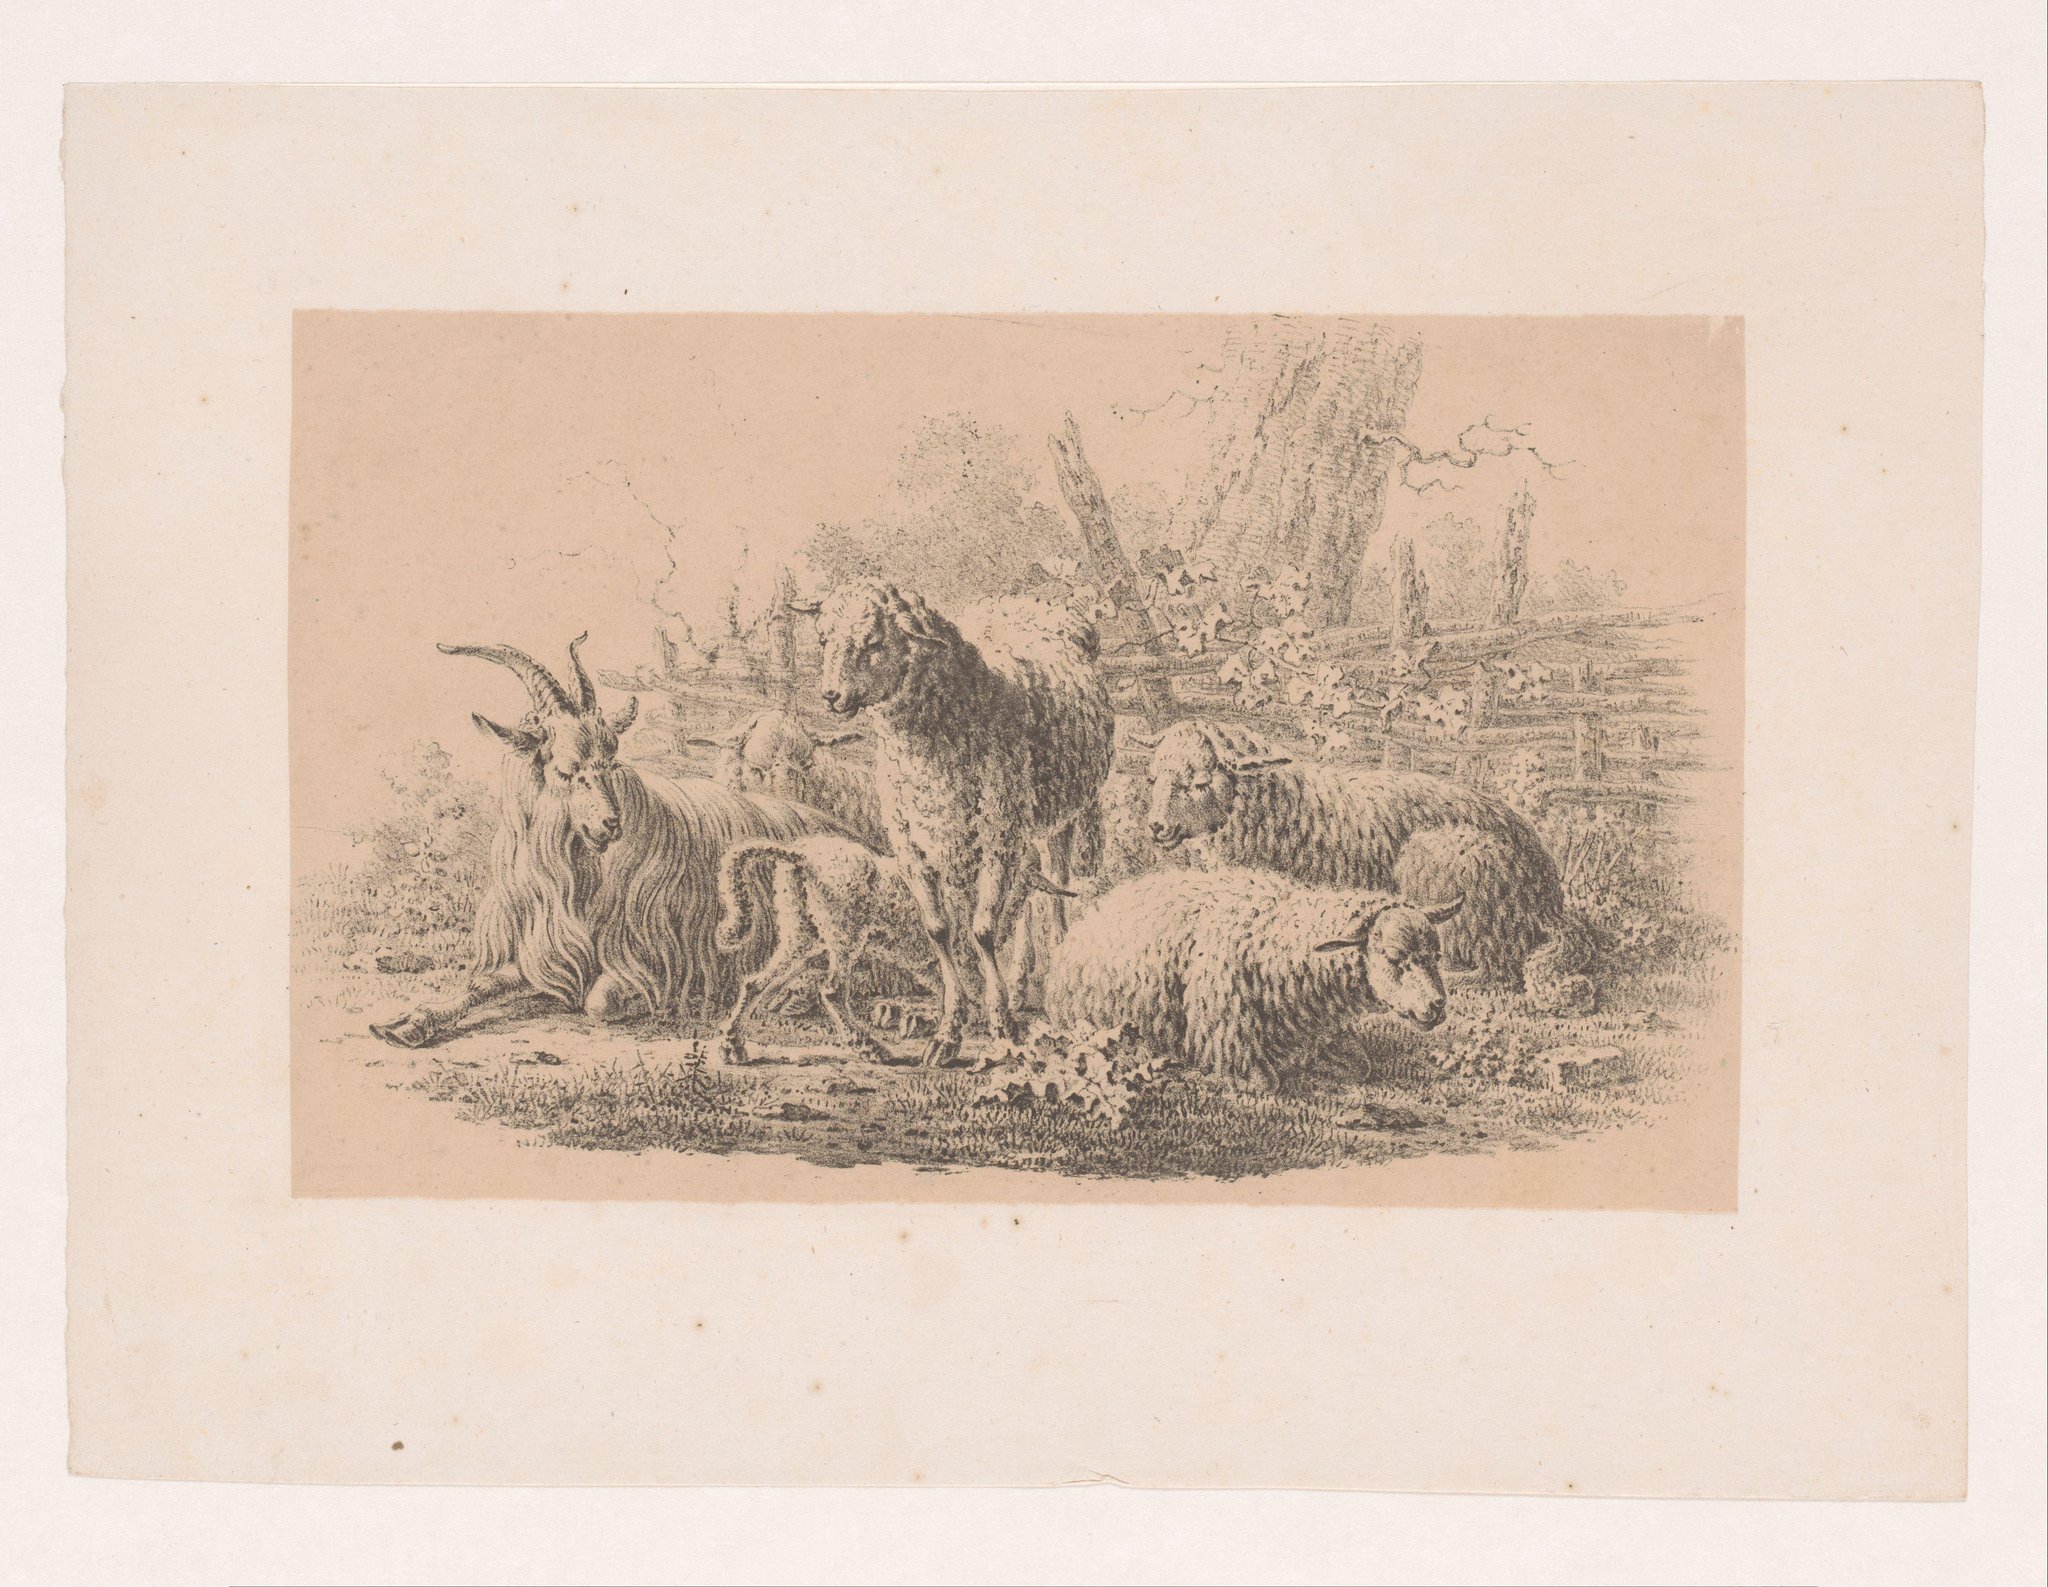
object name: print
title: Geitenbok, vijf schapen en een lam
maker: pieter de goeje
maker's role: draughtsman, print maker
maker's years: 1789-1859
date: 1809-1859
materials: paper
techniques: tone lithography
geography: netherlands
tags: sheep (+ feeding and care of young), fence, wall, paling, he-goat, billy-goat, lamb, ewe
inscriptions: collector's mark: Lugt 2228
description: Een van de schapen staat en zoogt een lam. Achter de dieren staat een houten hek.